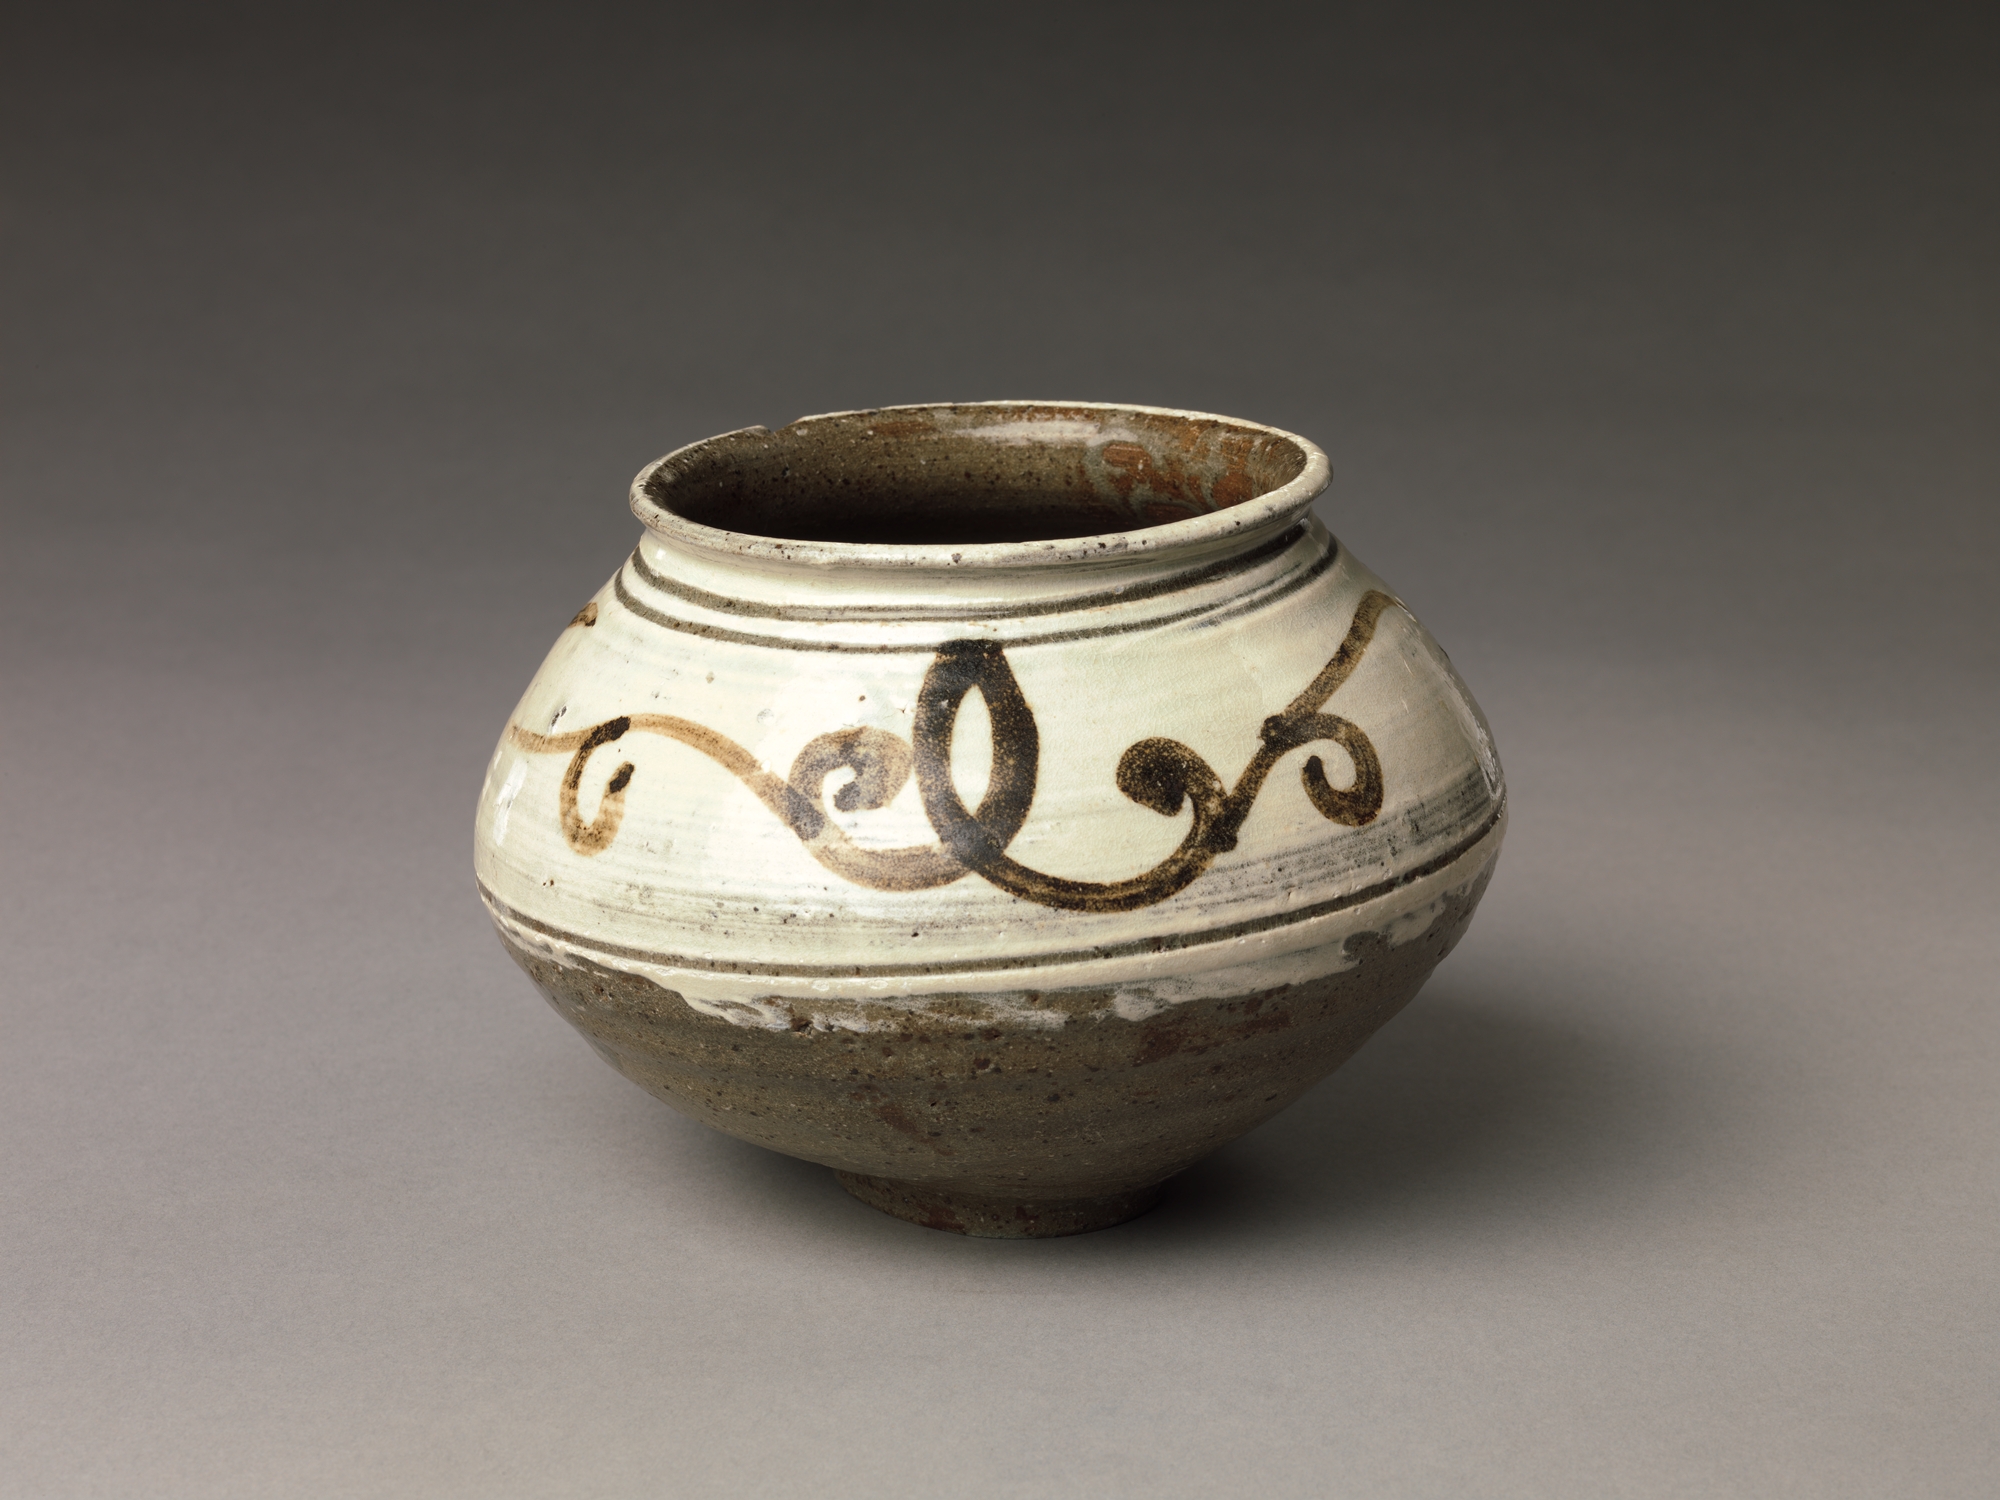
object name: jar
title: Jar with floral scroll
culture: korean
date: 1467-1533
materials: iron